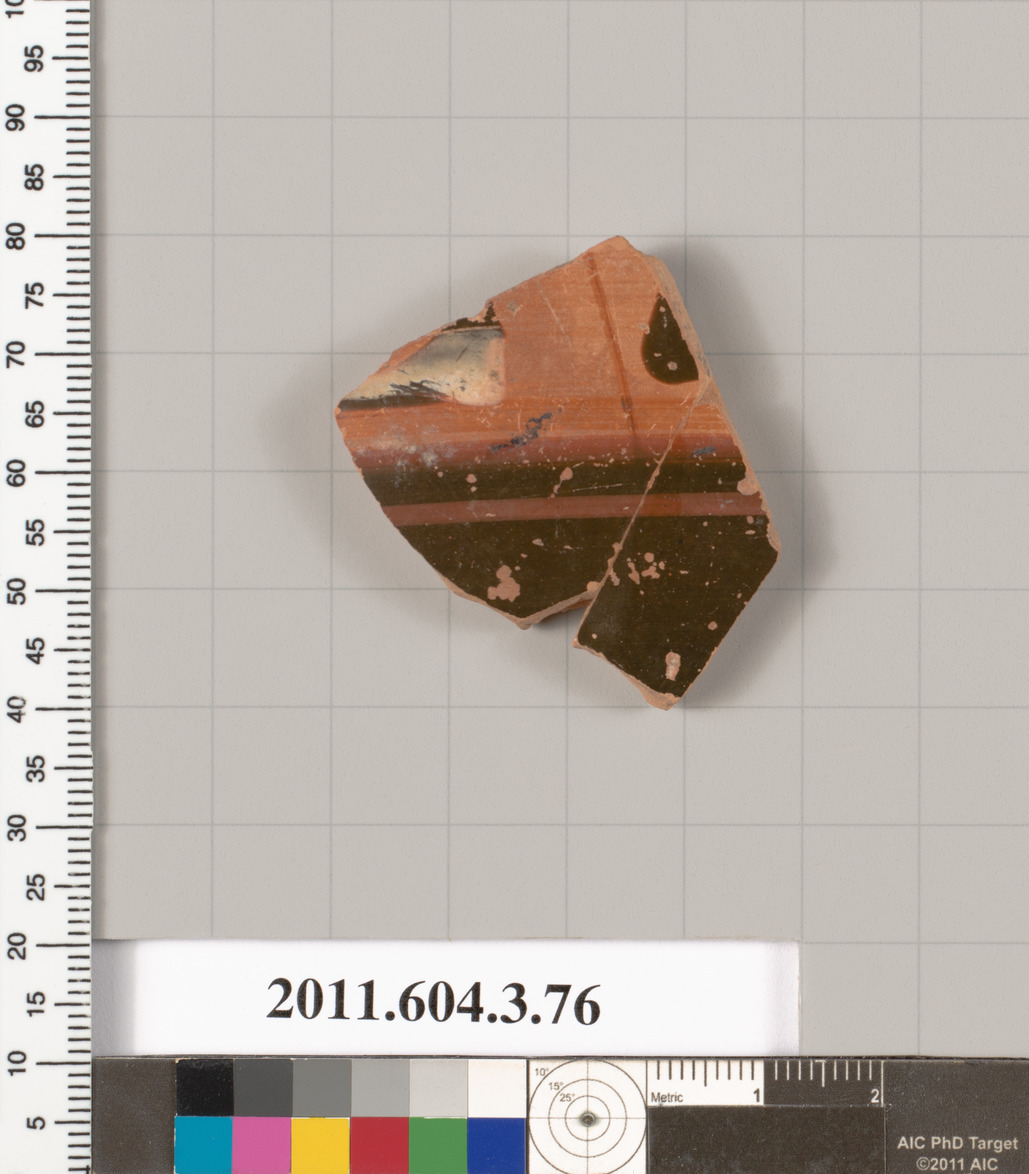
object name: amphora fragment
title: Terracotta fragment of an amphora (jar)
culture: greek, attic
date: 530-520 BCE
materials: terracotta